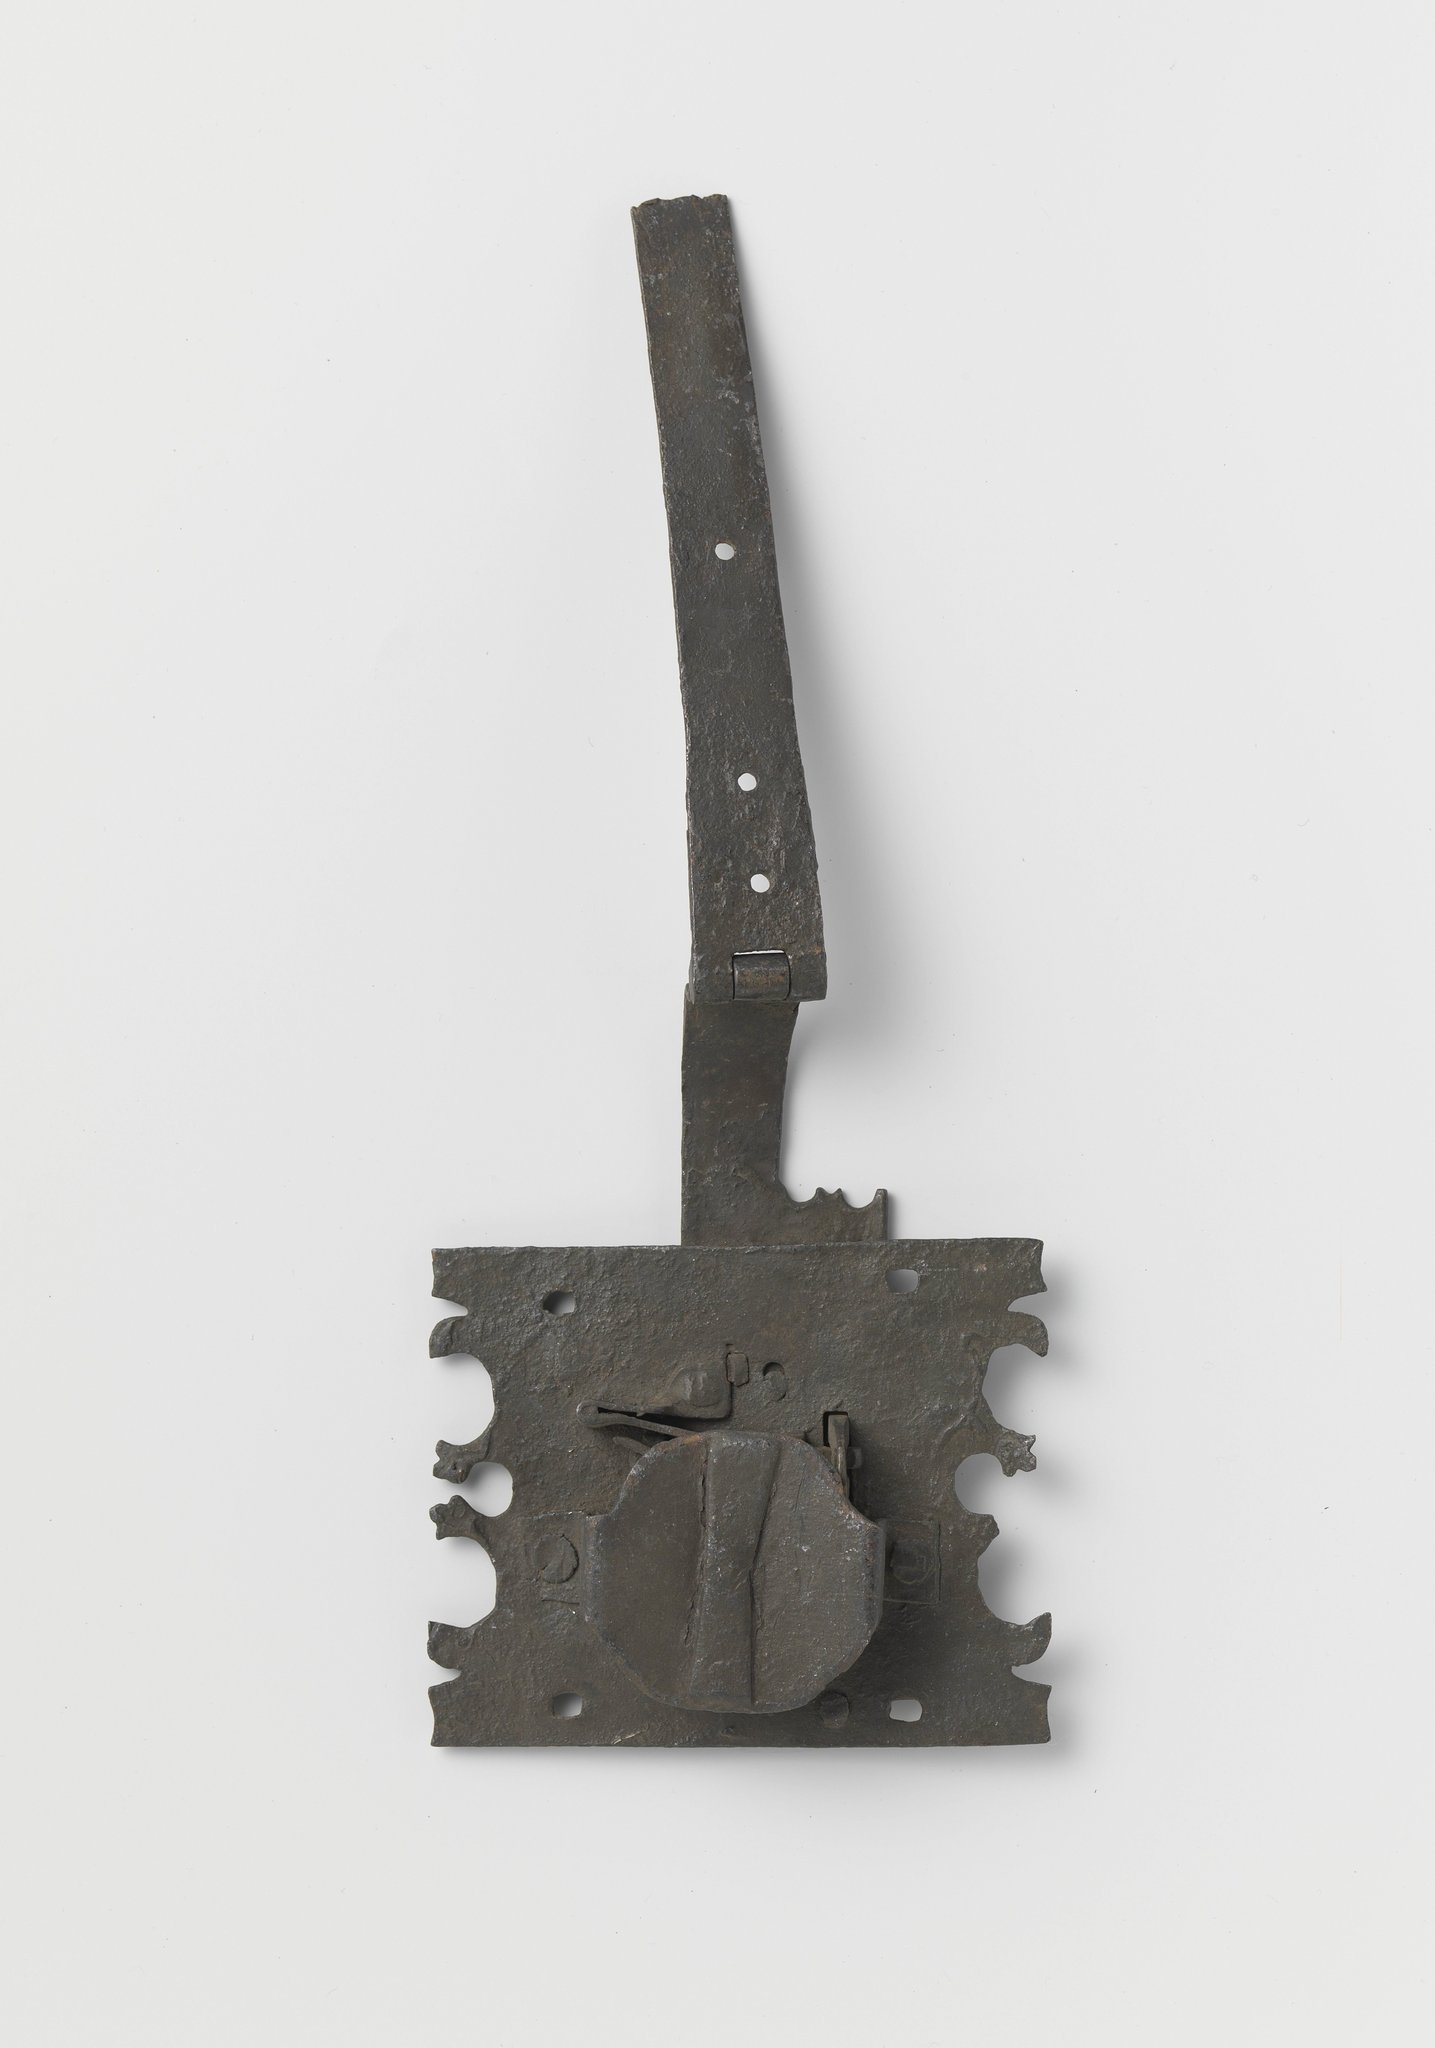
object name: slotplaat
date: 1400-1950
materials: iron